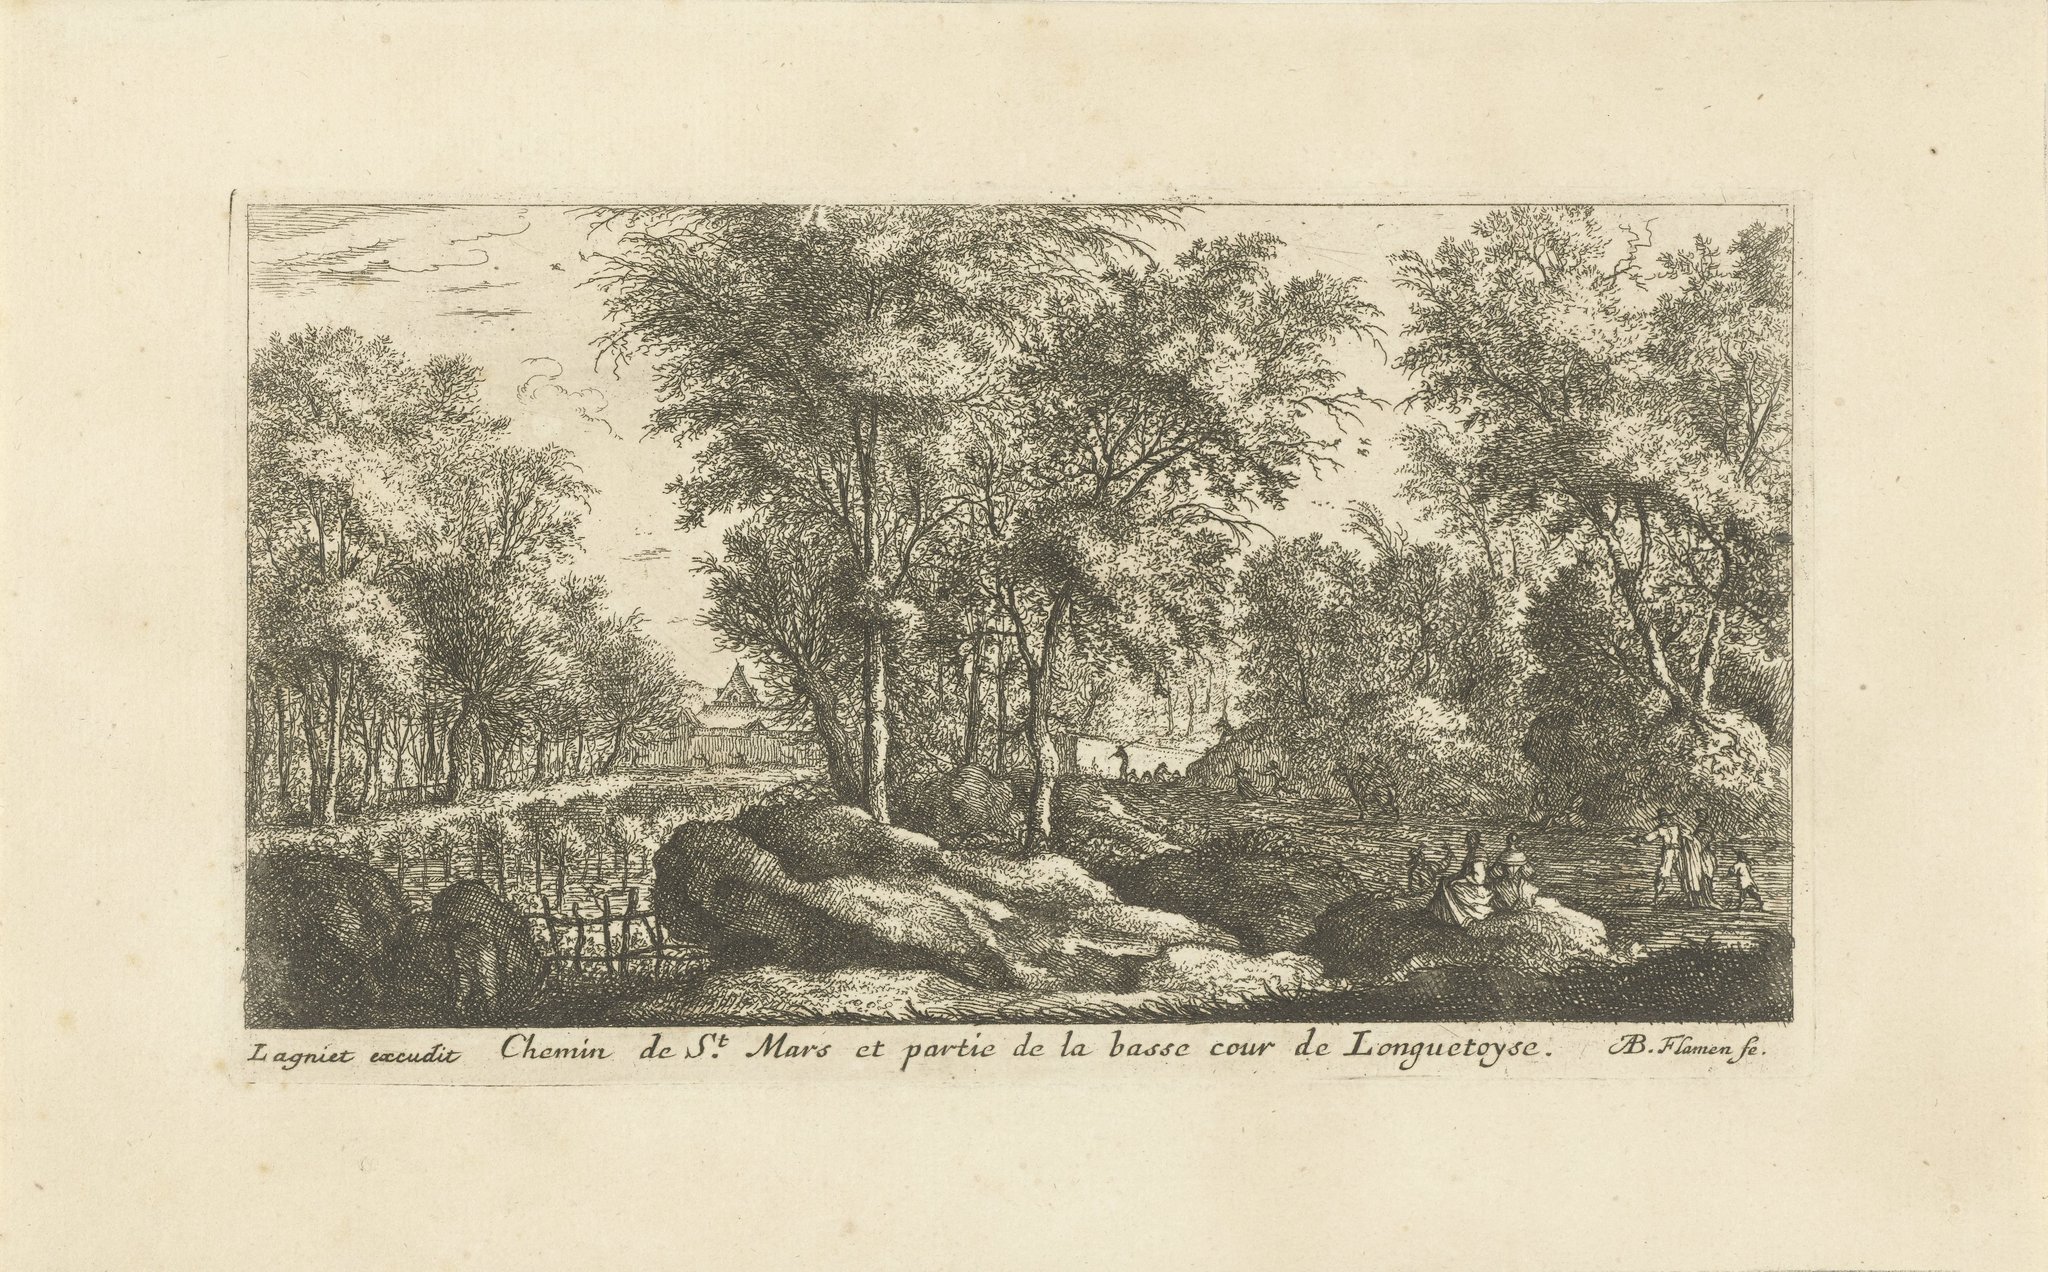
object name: print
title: Gezichten op kasteel Longuetoise en omgeving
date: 1648-1672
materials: paper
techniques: etching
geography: france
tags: forest path or lane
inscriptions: collector's mark: Lugt 2228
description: Een landschap met hoge bomen en op de achtergrond een deel van de omheining en het dak van kasteel Longuetoise. Op het pad tussen de bomen lopen mannen, vrouwen en kinderen. Op een rots langs het pad zitten twee vrouwen.